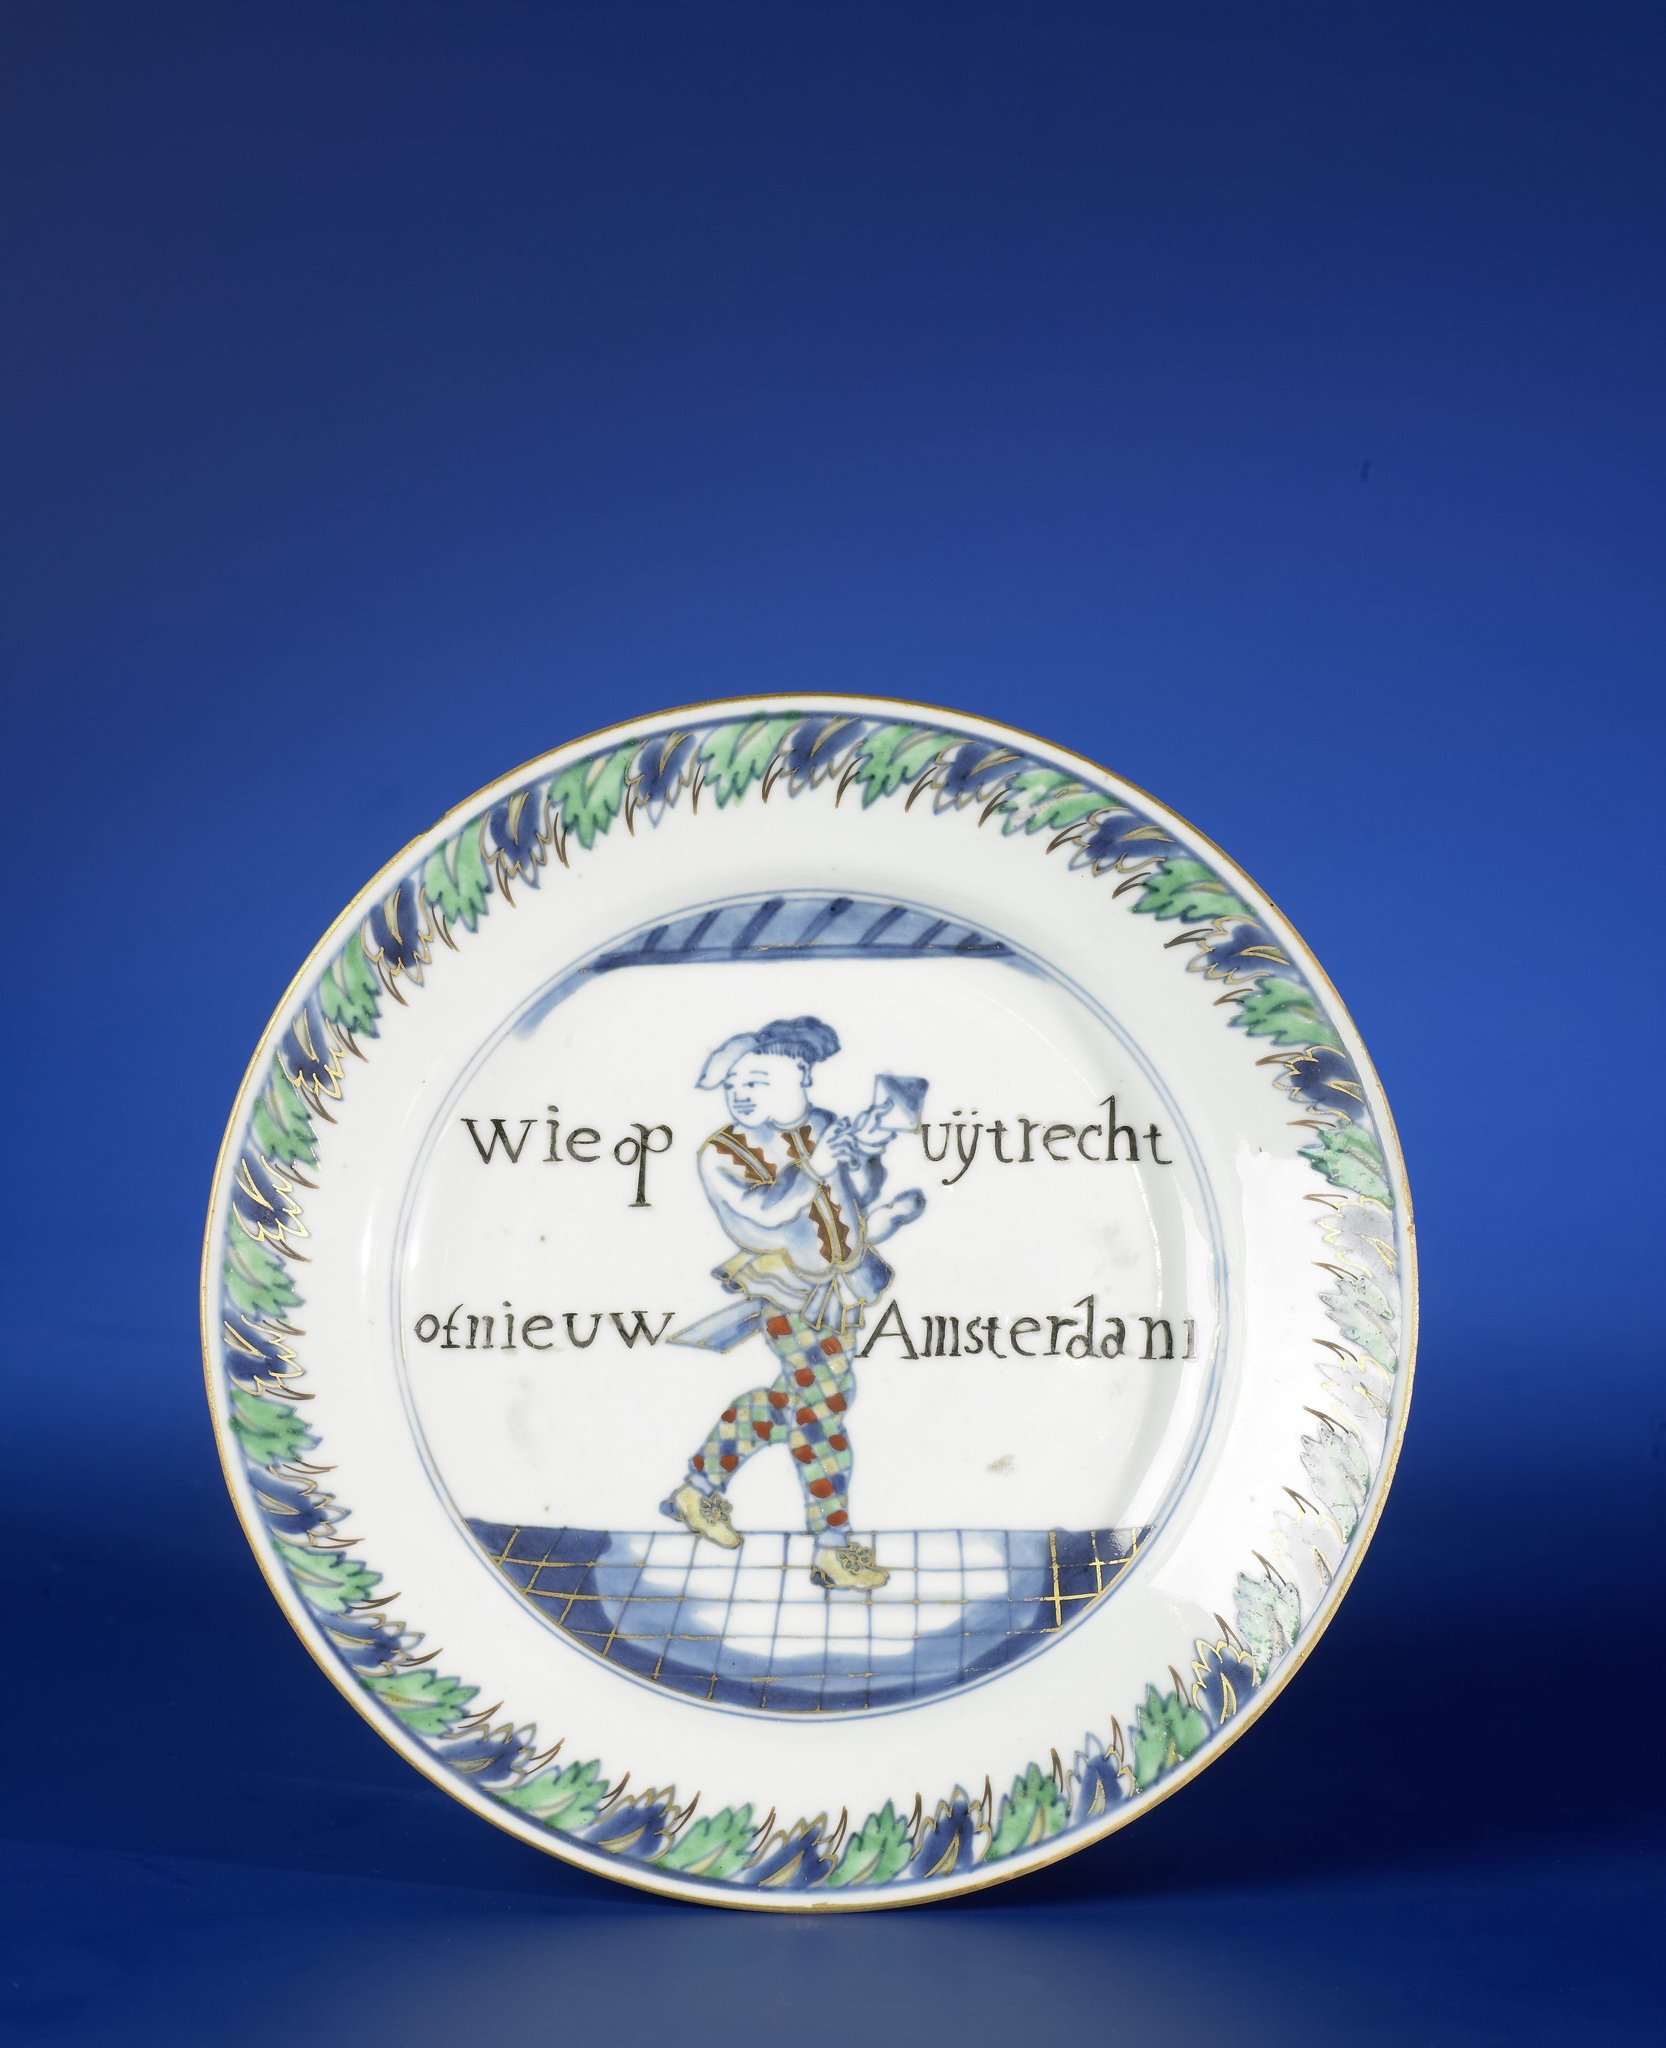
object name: plate dish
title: Plate with a caricatural figure and inscription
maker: Anonymous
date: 1725-1749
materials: cobalt, glaze, gold, paint, porcelain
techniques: firing, gilding, turning, vitrification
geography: china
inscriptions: inscription: ‘Wie op Uijtrecht of nieuw Amsterdam’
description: Bord van porselein, beschilderd in onderglazuur blauw en op het glazuur groen, zwart en goud. Op het plat een harlekijn met de tekst: 'Wie op Uijtrecht of nieuw Amsterdam'; de rand met een decoratief patroon. Actie-bord. Europese voorstelling in blauw-wit met emailkleuren.